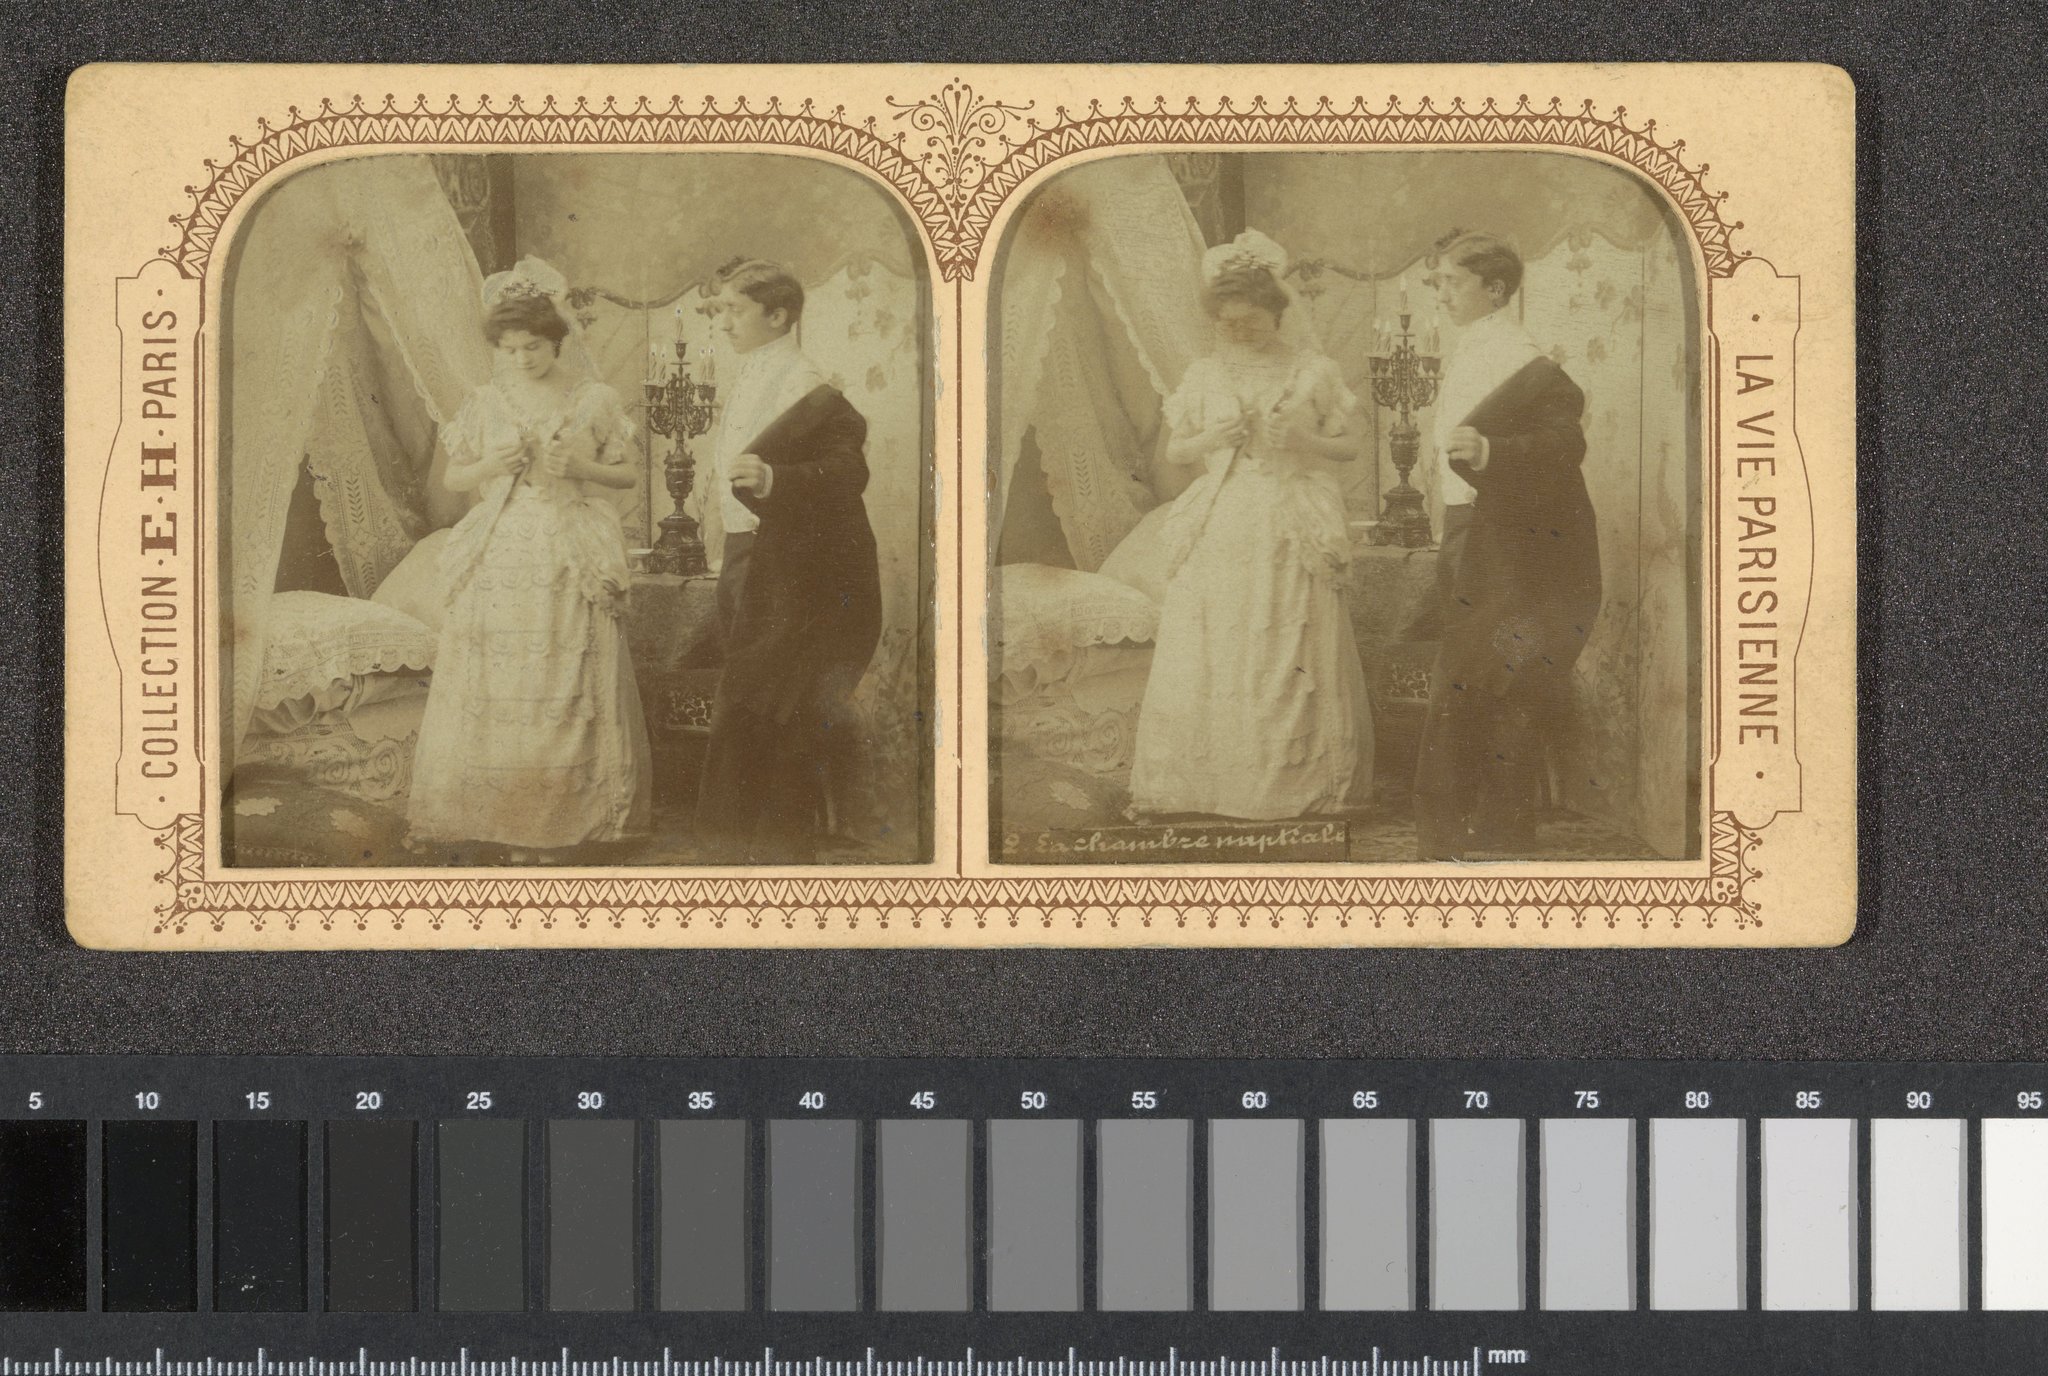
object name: stereograph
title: Scènes de la vie parisienne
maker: eugène hanau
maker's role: publisher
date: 1870-1890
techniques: albumen print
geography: paris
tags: undressing oneself, getting undressed